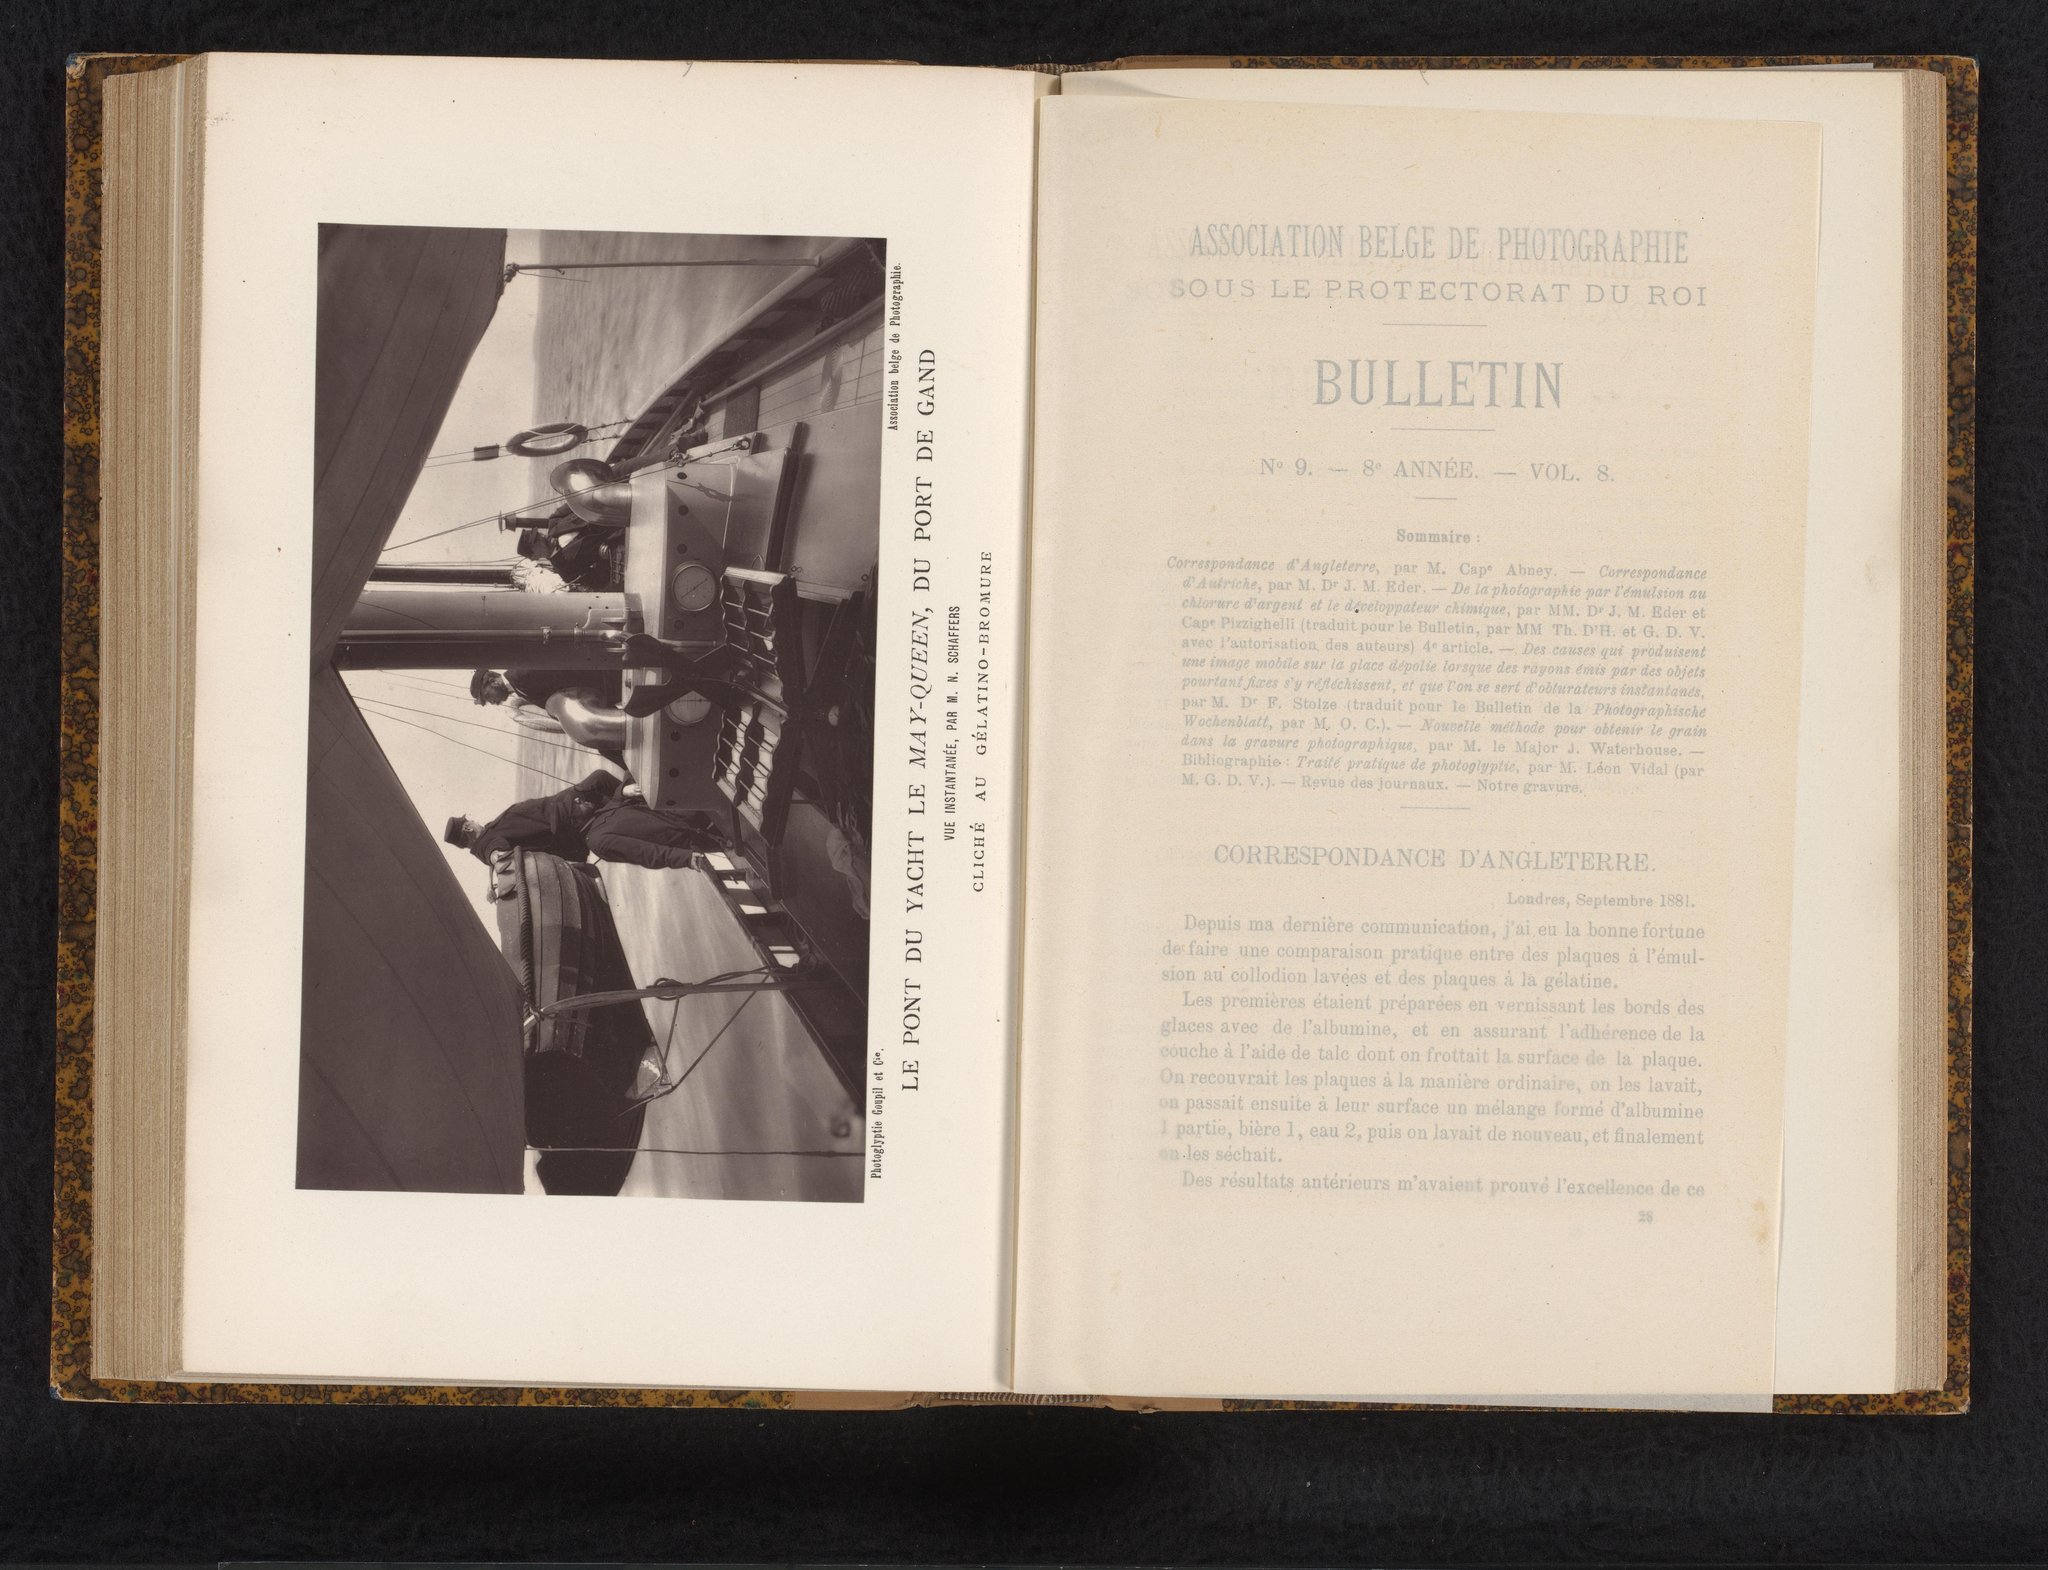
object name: photomechanical print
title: Le pont du yacht le May-Queen, du port de Gand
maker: paul joseph nicolas nestor schaffers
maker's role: fotograaf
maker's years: 1826-1896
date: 1876-1881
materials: cardboard, paper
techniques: woodburytype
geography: paris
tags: crew ~ ship, parts of ship's exterior: deck, ghent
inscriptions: inscription: ‘Vue instantanée (...) Cliché au gélatino-bromure’